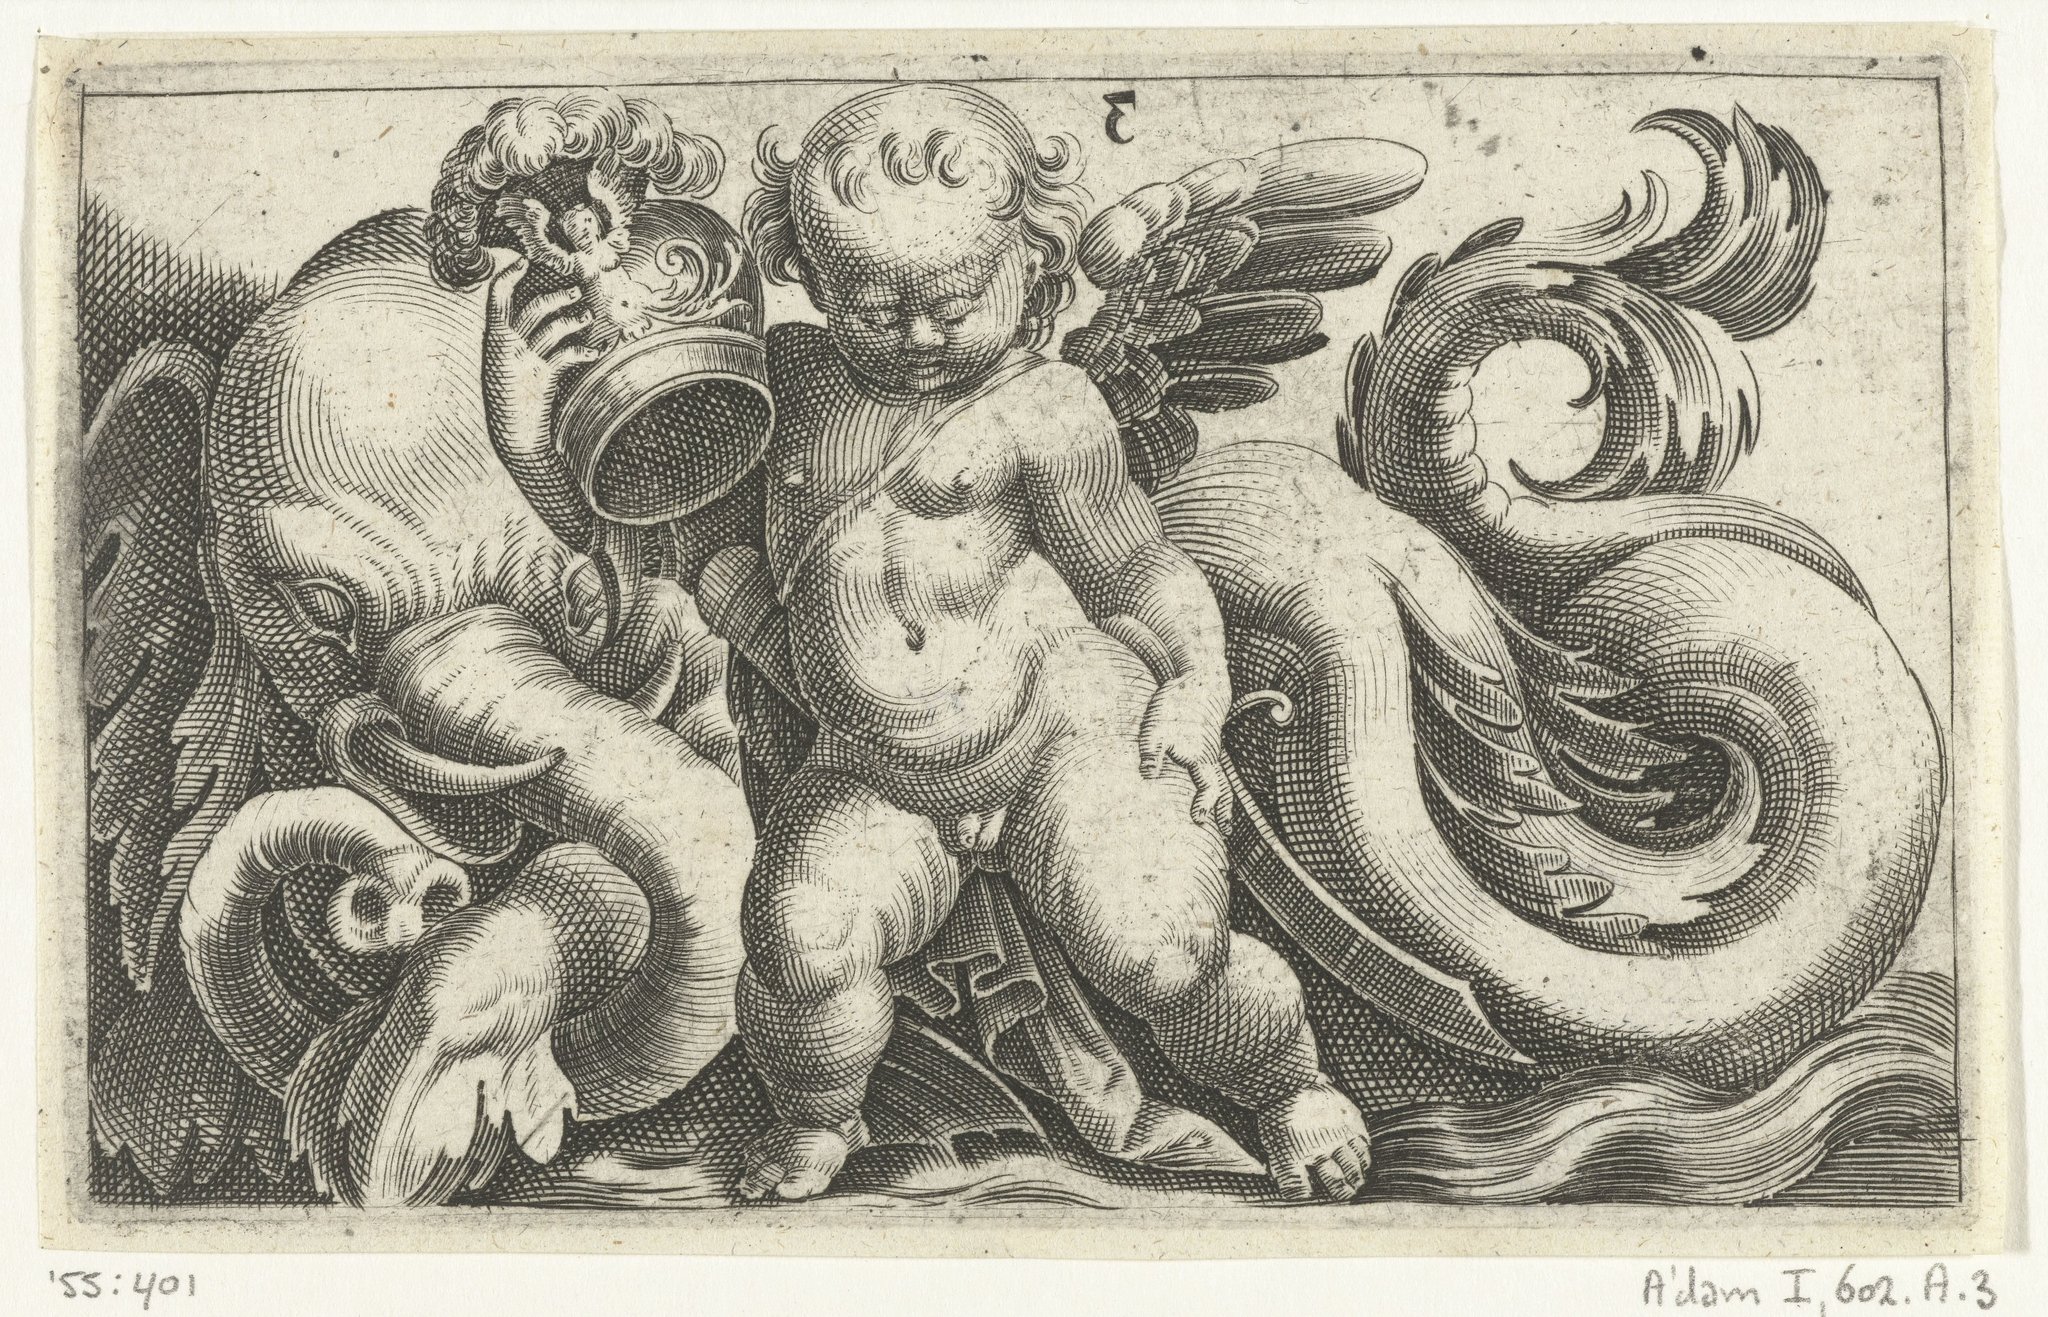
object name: ornament print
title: Putti op zeewezens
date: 1605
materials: paper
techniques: engraving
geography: germany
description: Tegenzijdige kopie naar een prent van Giovanni Andrea Maglioli.